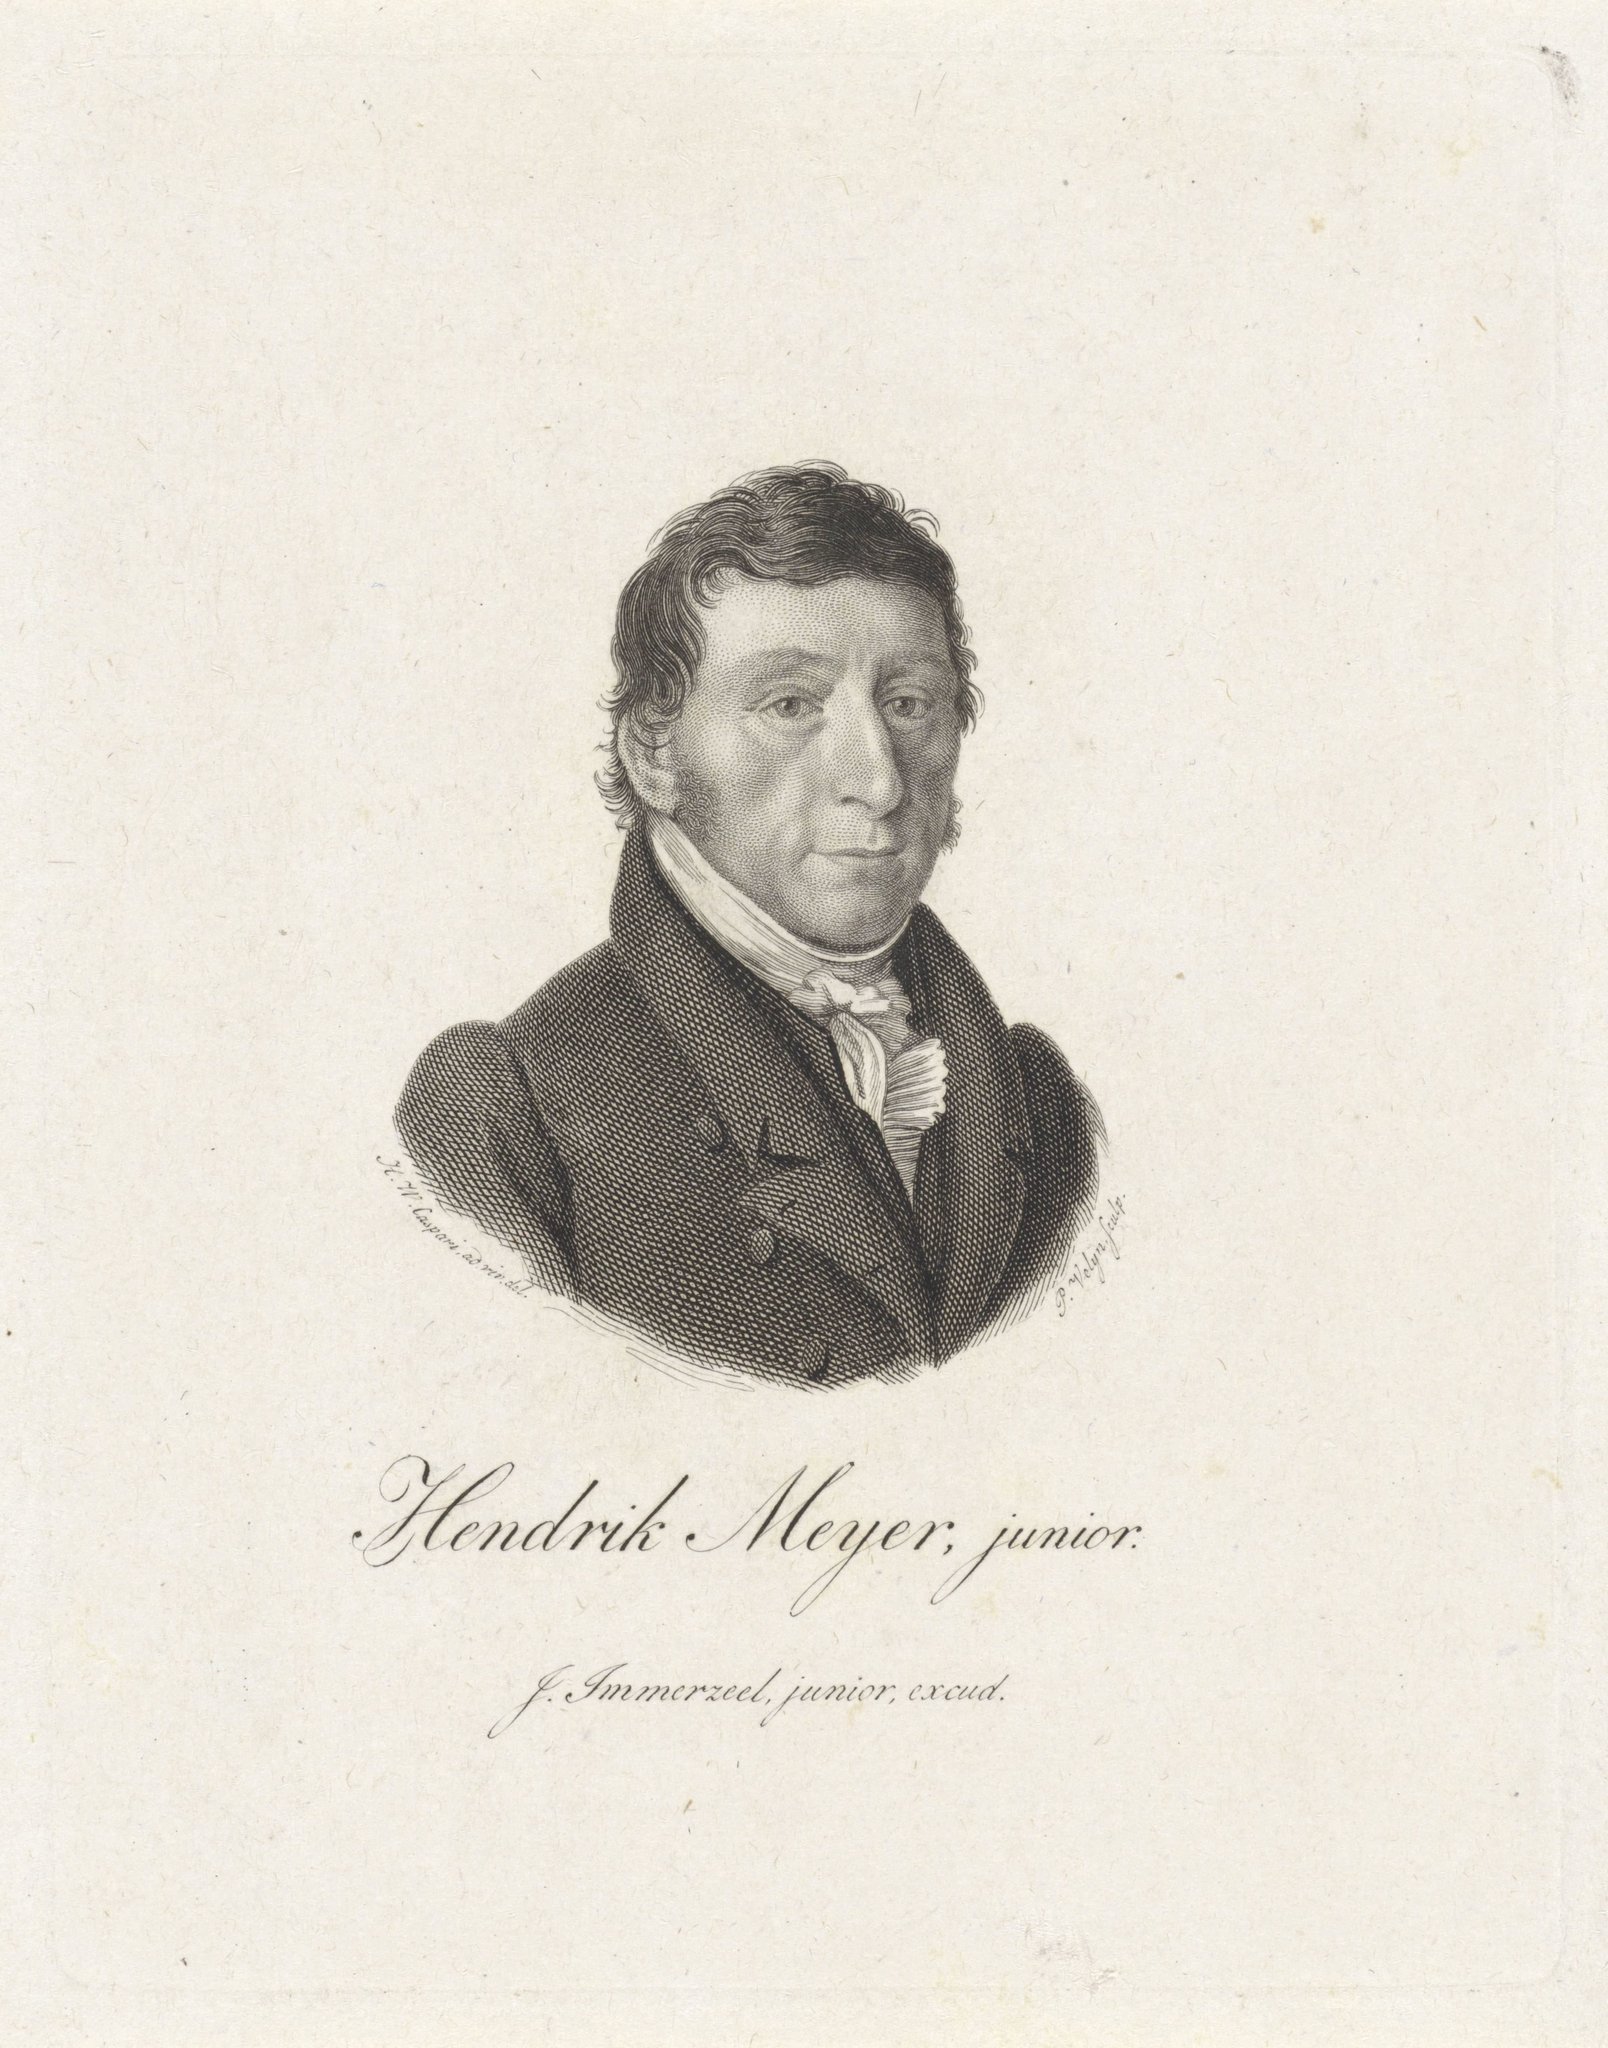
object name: print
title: Portret van Hendrik Meyer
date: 1829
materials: paper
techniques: engraving, etching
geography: netherlands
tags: dichter, koopman, hendrik meyer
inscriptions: collector's mark: Lugt 2228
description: Prent volgens Van Someren ook gebruikt in: Nederlandsche Muzen-Almanak. Rotterdam: J. Immerzeel, 1829.